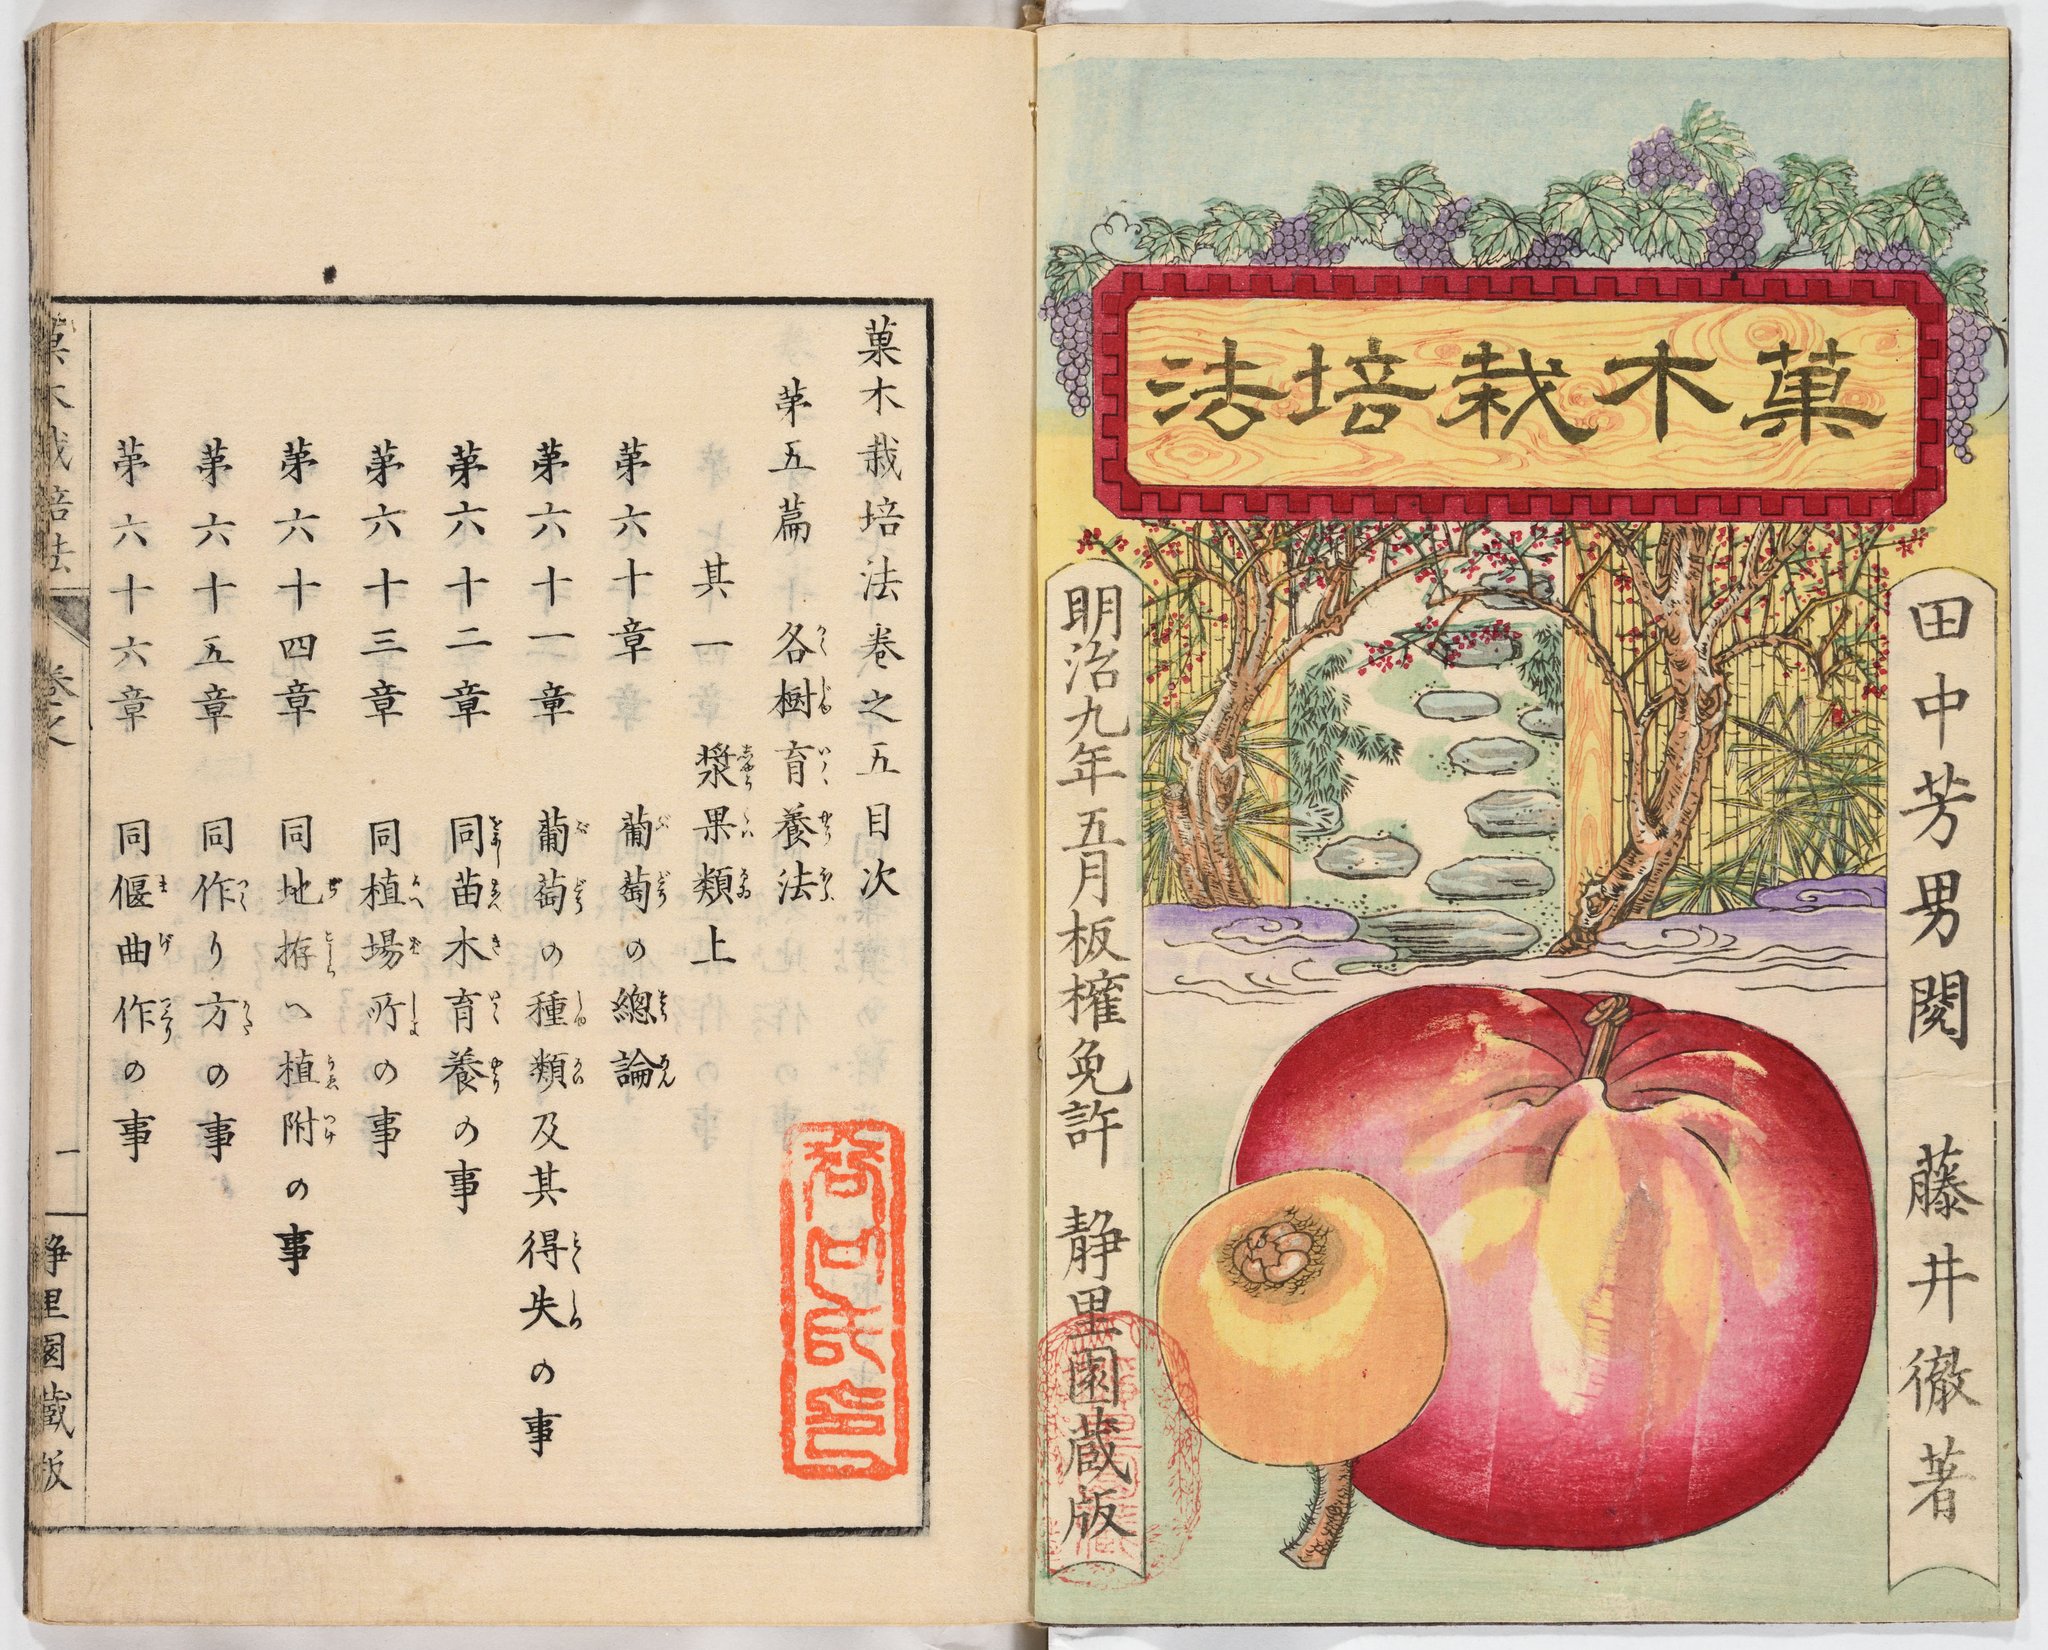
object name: illustrated book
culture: japanese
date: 1893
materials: ink, paper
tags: fruit